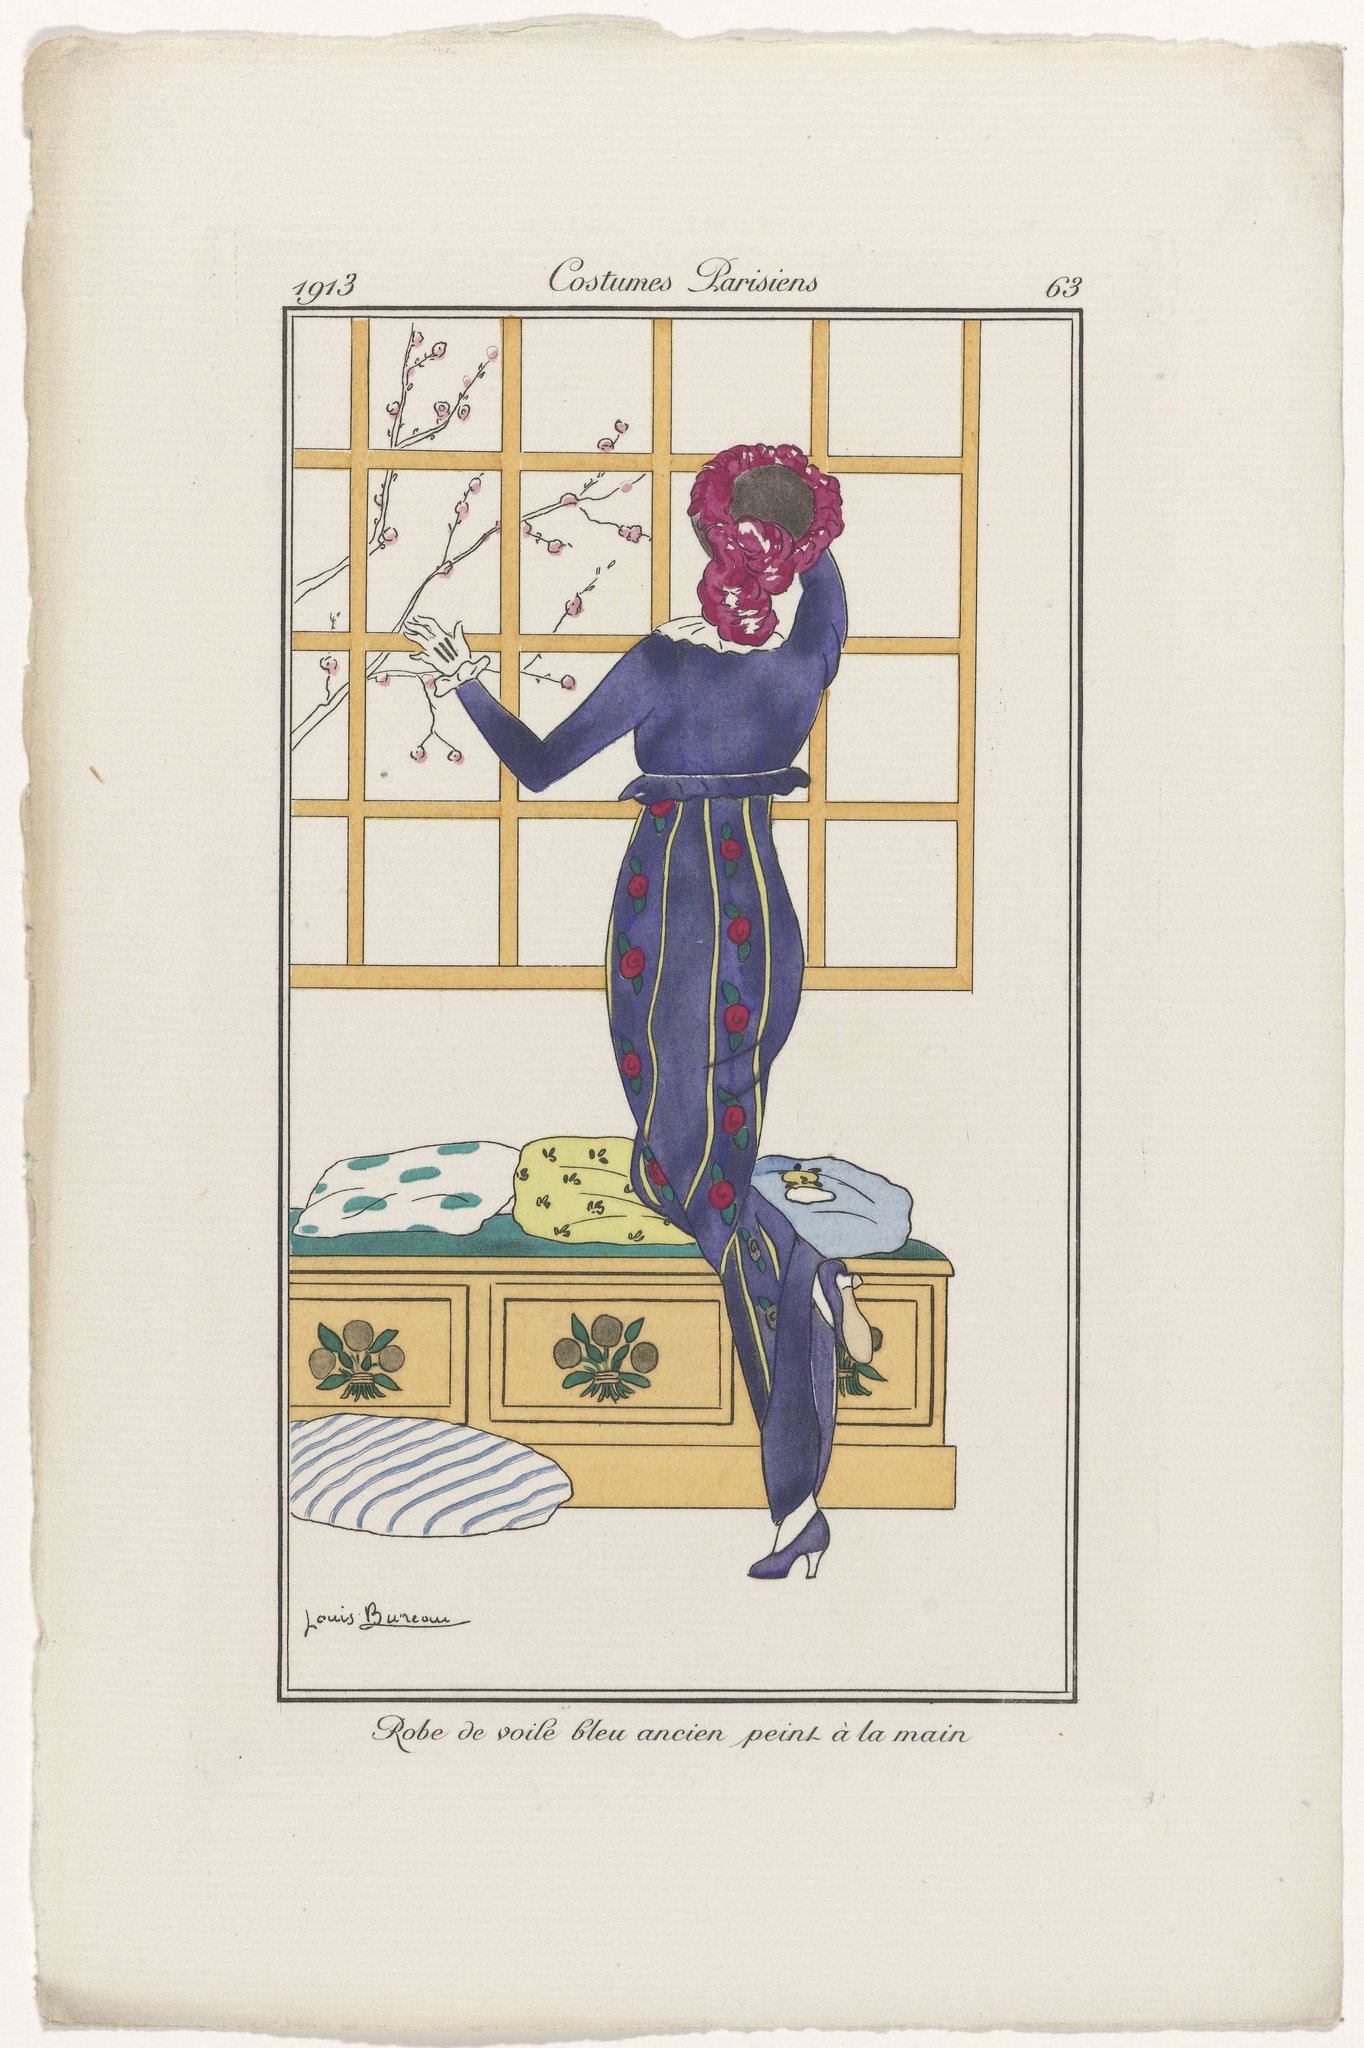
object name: fashion print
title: Journal des Dames et des Modes, Costumes Parisiens, 1913, No. 63 : Robe de voil (...)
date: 1913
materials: paper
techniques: engraving, hand coloring, pochoir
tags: head-gear (+ women's clothes), fashion plates, dress, gown (+ women's clothes), human figure at (open) window, seen from inside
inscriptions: caption: ‘Robe de voile bleu ancien peint à la main’, title: ‘Costumes Parisiens’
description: Vrouw bij venster, op de rug gezien, in een japon van antiekblauwe voile met de hand beschilderd. Pumps met contrasterende hakken. Prent uit het modetijdschrift Journal des Dames et des Modes (1912-1914).